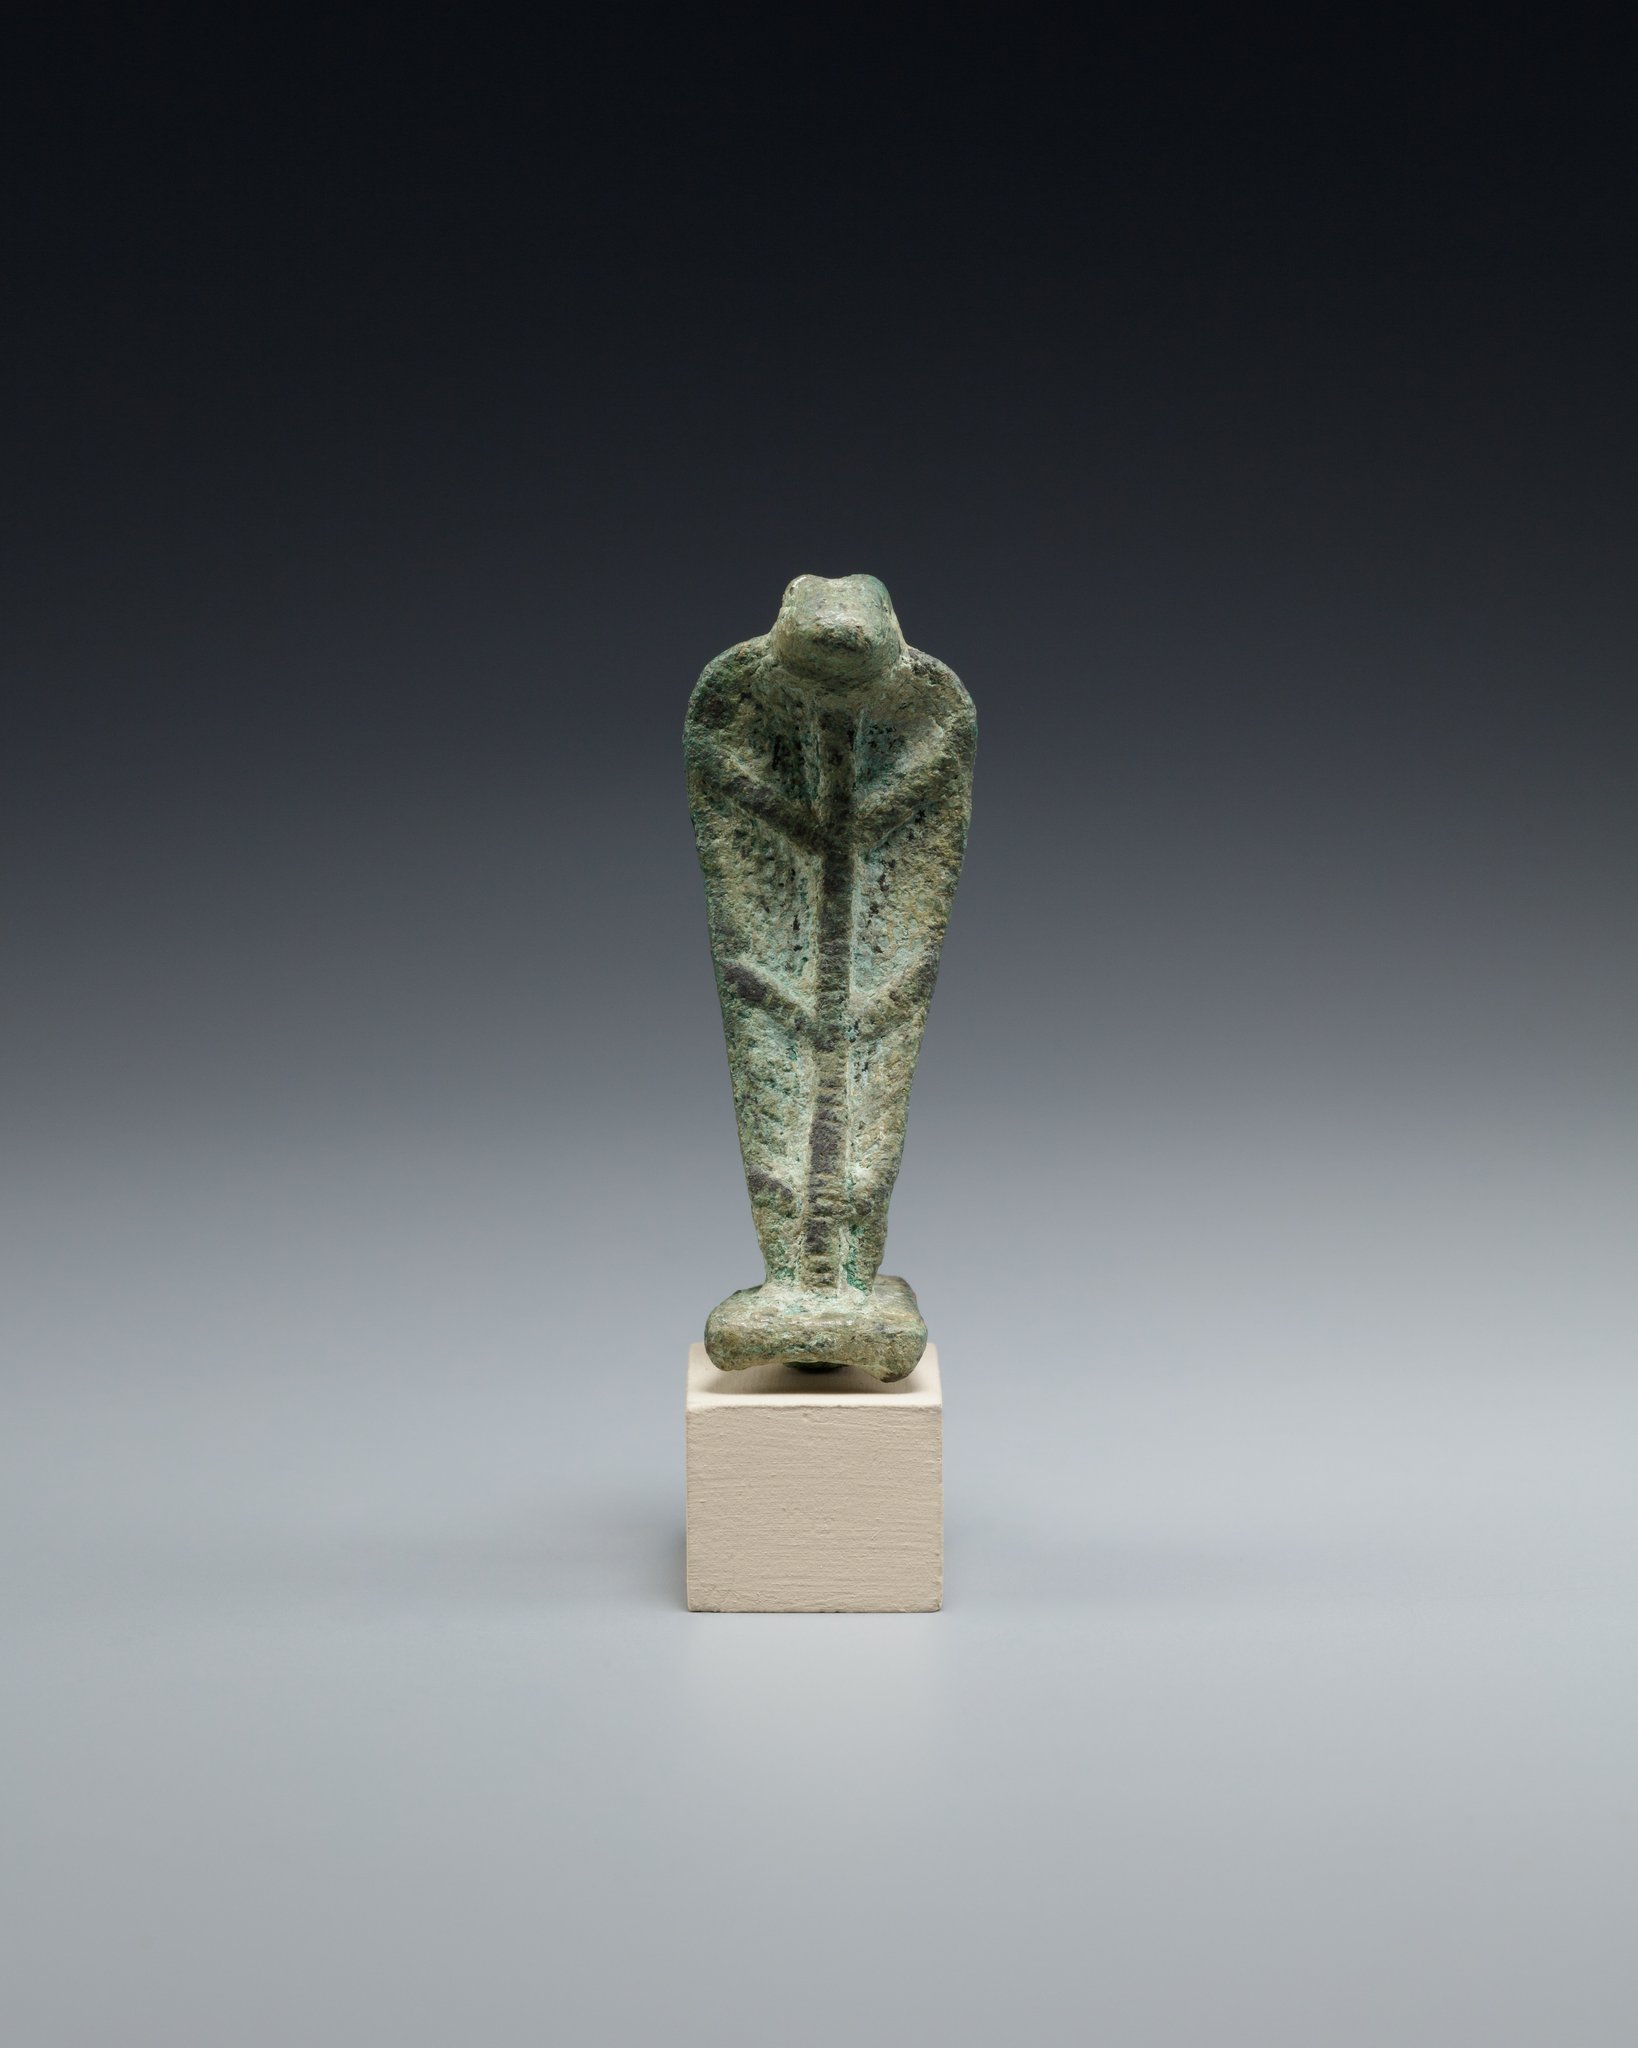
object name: figurine, cobra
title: Cobra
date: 664-630 BCE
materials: metal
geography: egypt